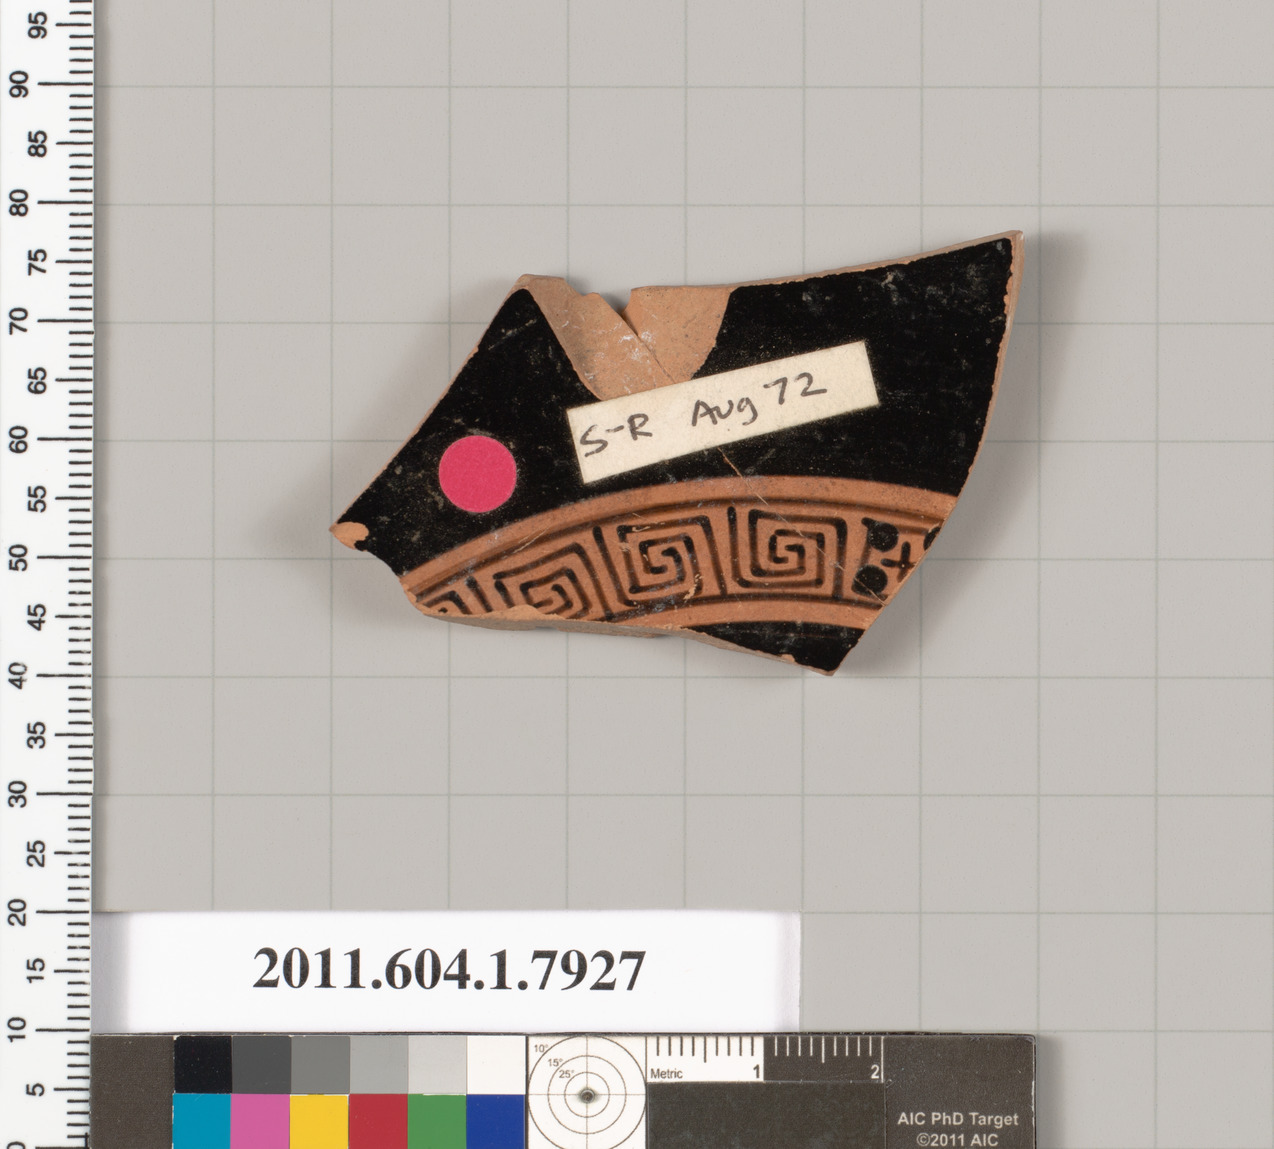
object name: kylix fragment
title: Terracotta fragment of a kylix (drinking cup)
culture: greek, attic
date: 460-450 BCE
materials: terracotta